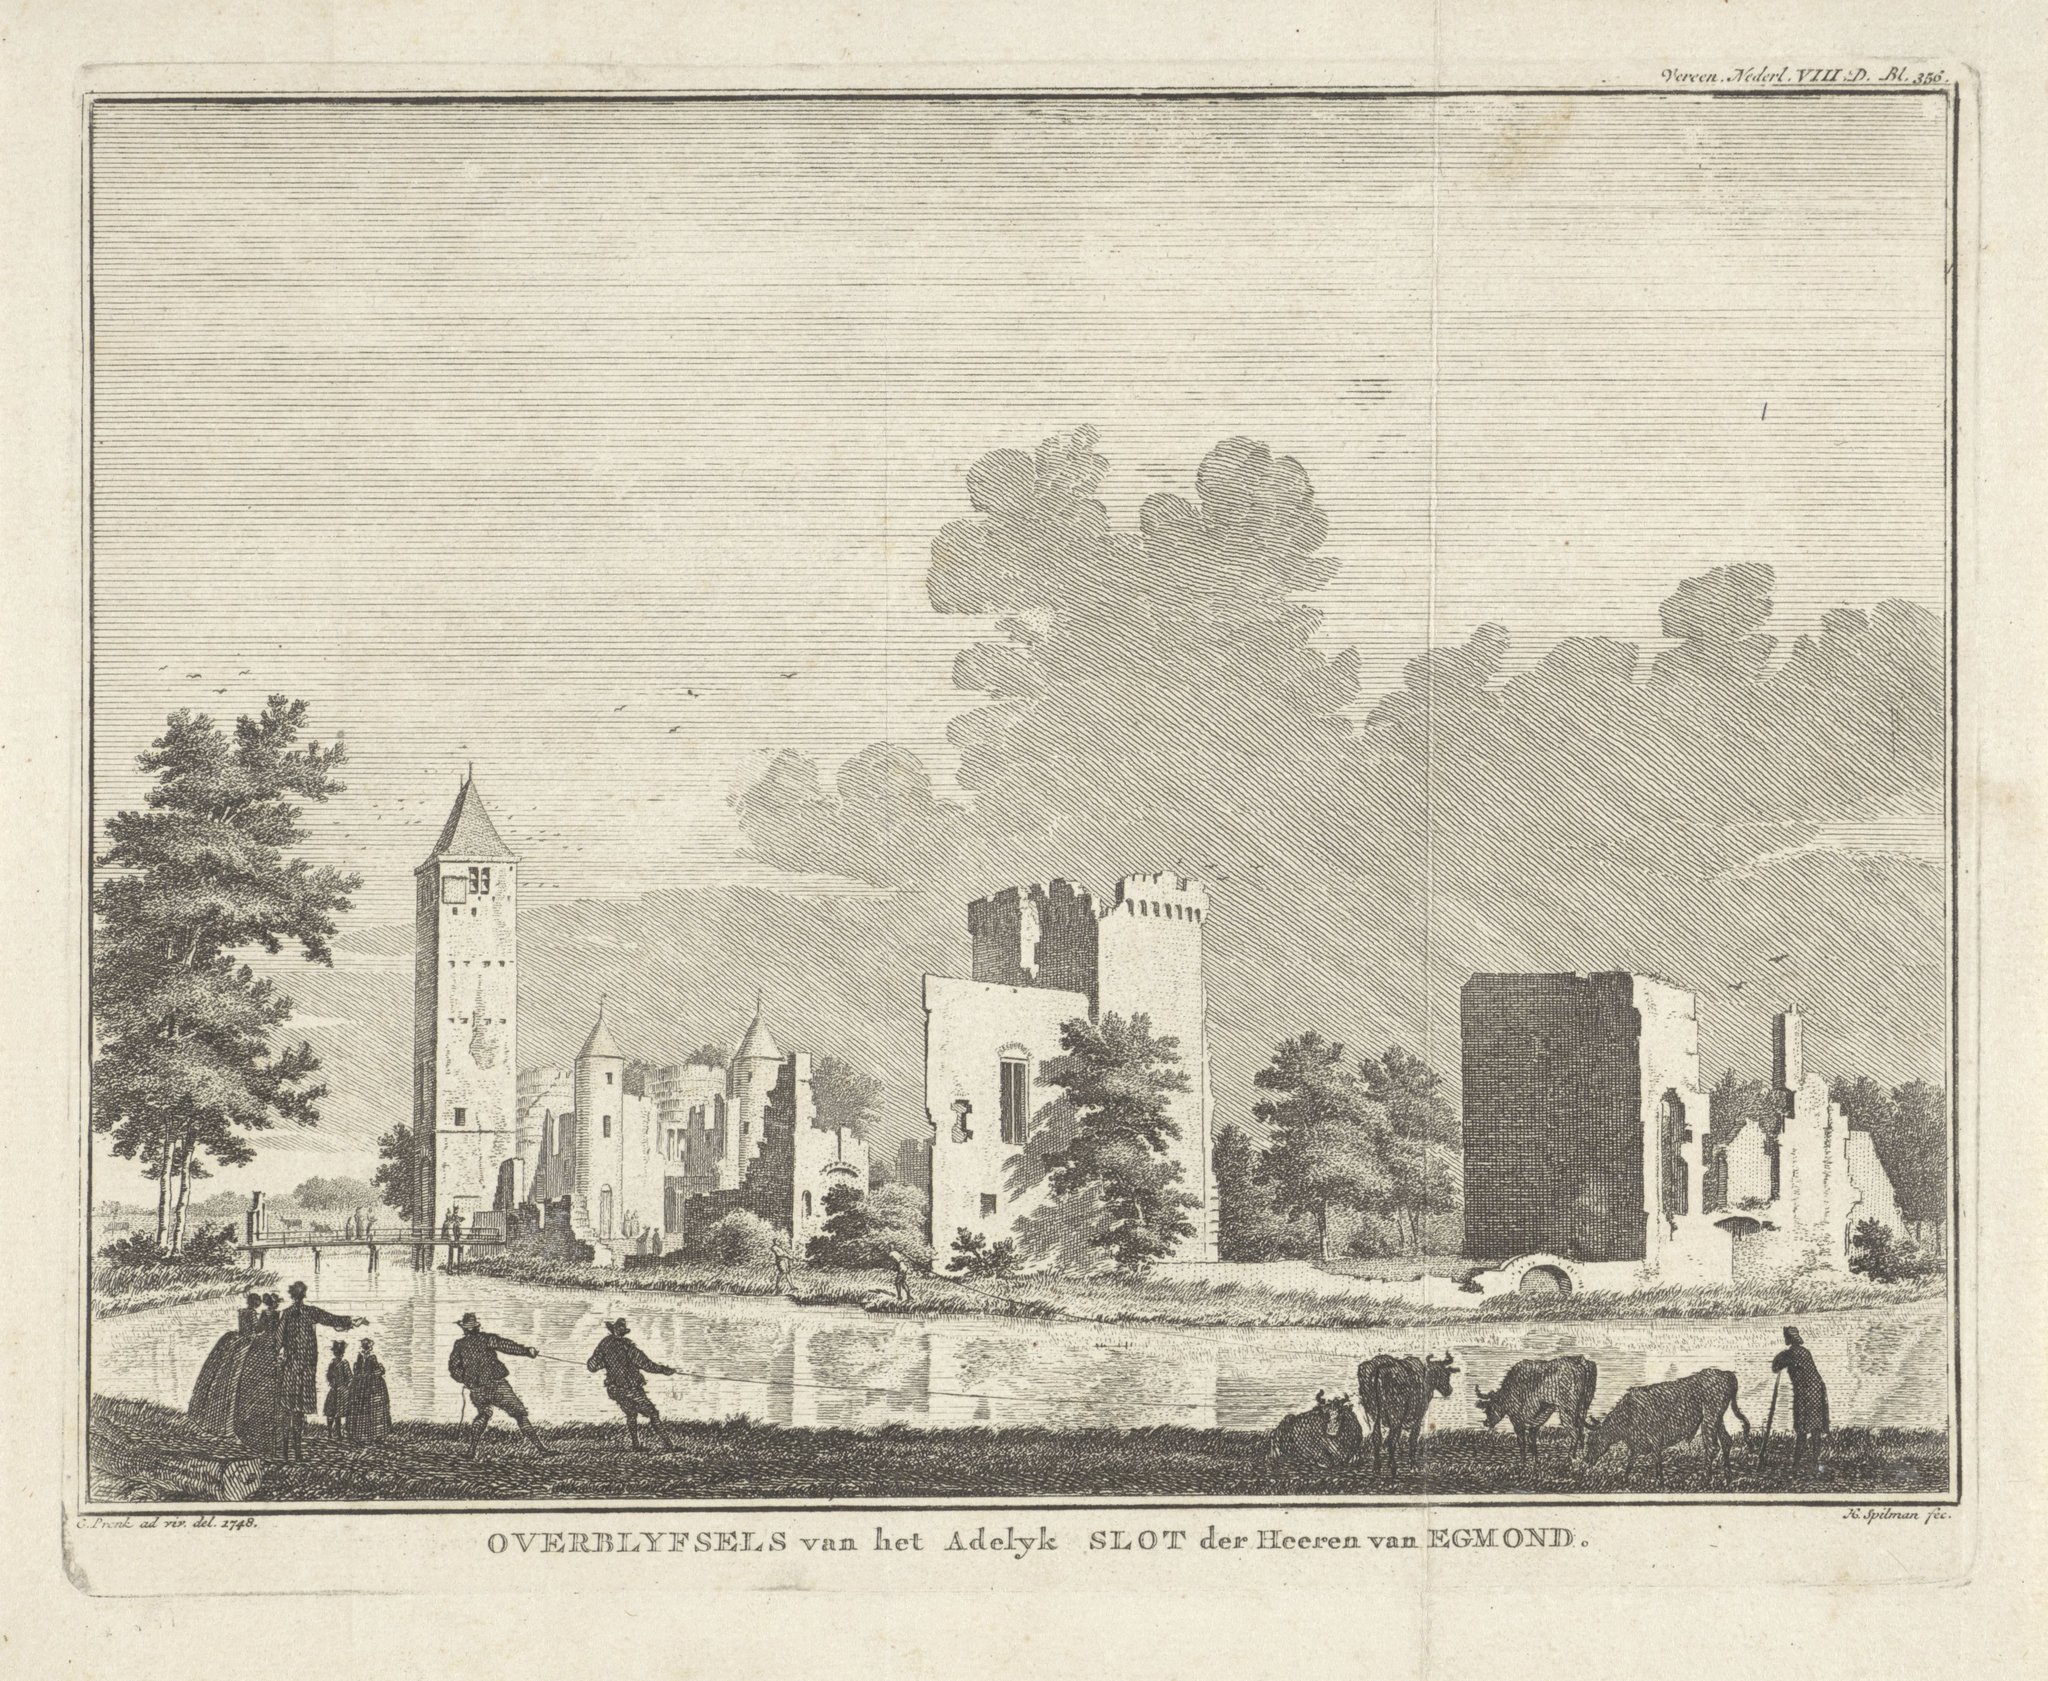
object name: print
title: Overblyfsels van het Adelijk Slot der Heeren van Egmond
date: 1748-1784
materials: paper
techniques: etching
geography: haarlem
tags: landscape with ruins (+ city(-scape) with figures, staffage)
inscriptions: collector's mark: Lugt 2228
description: Figuren en koeien aan de waterkant bij de ruïnes van kasteel van Egmond. Rechtsboven: Vereen. Nederl. VIII. D. Bl. 356.